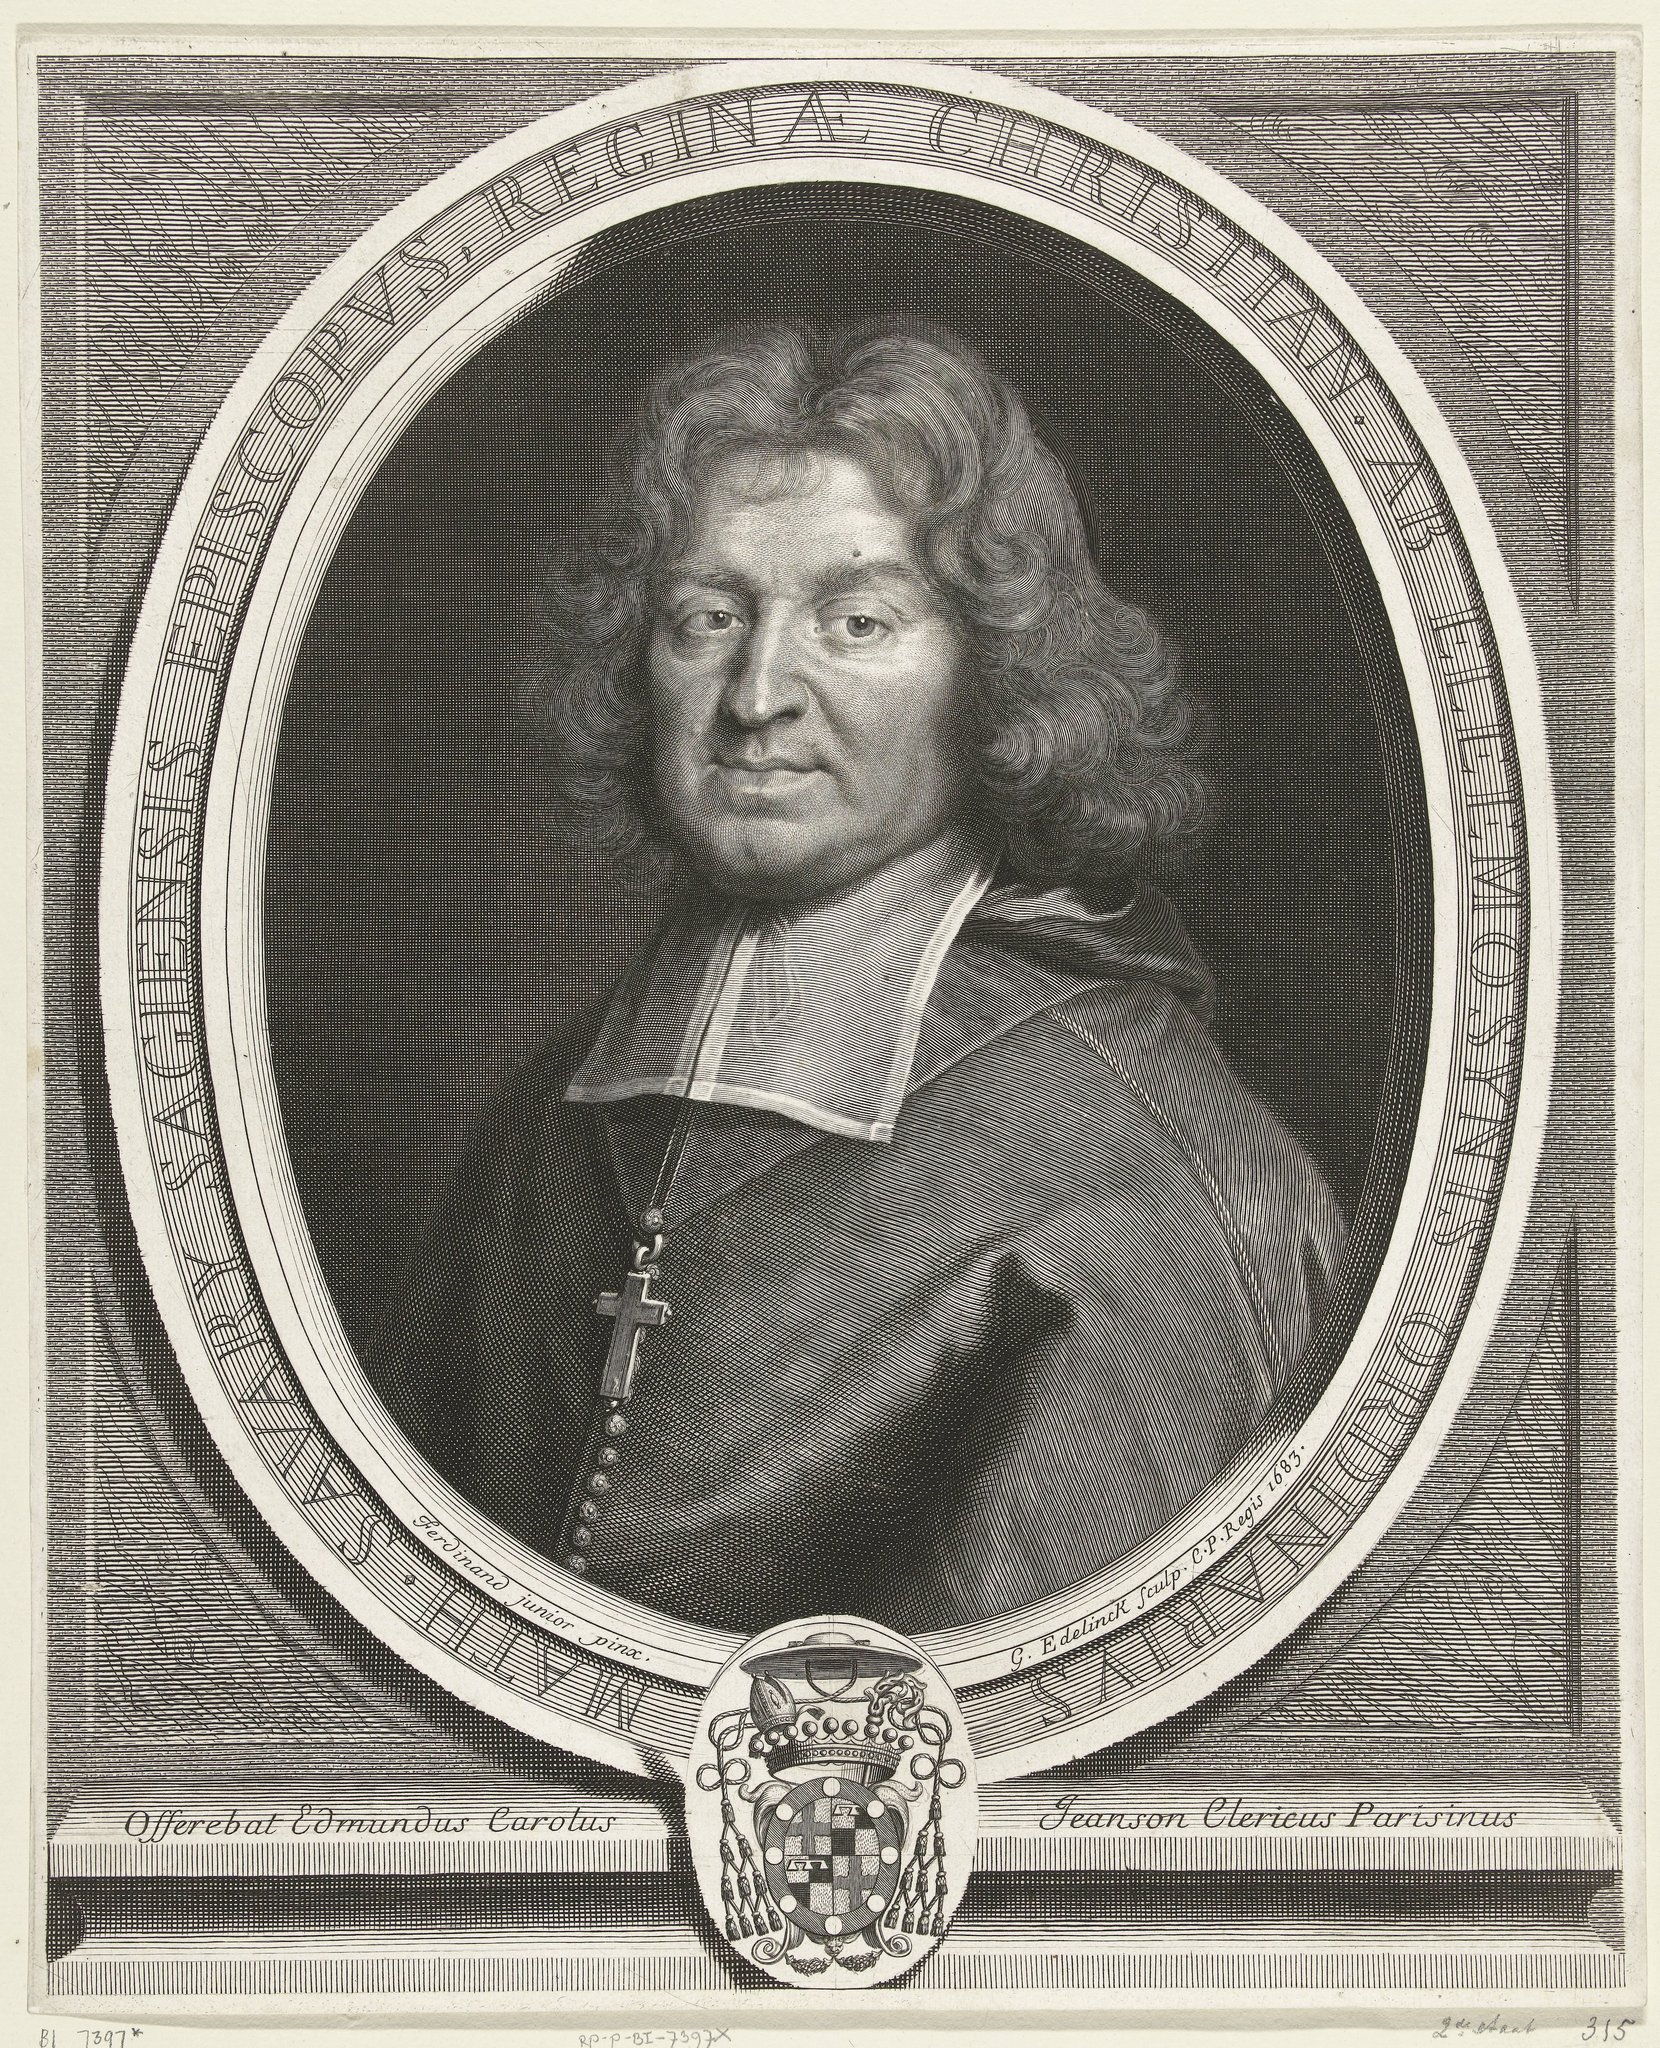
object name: print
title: Mathieu Savary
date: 1683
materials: paper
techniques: engraving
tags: france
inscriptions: collector's mark: Lugt 240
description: Portret van de Franse bisschop Mathurin Savary, afgebeeld in ovale omlijsting met tekst in Latijn en wapen.